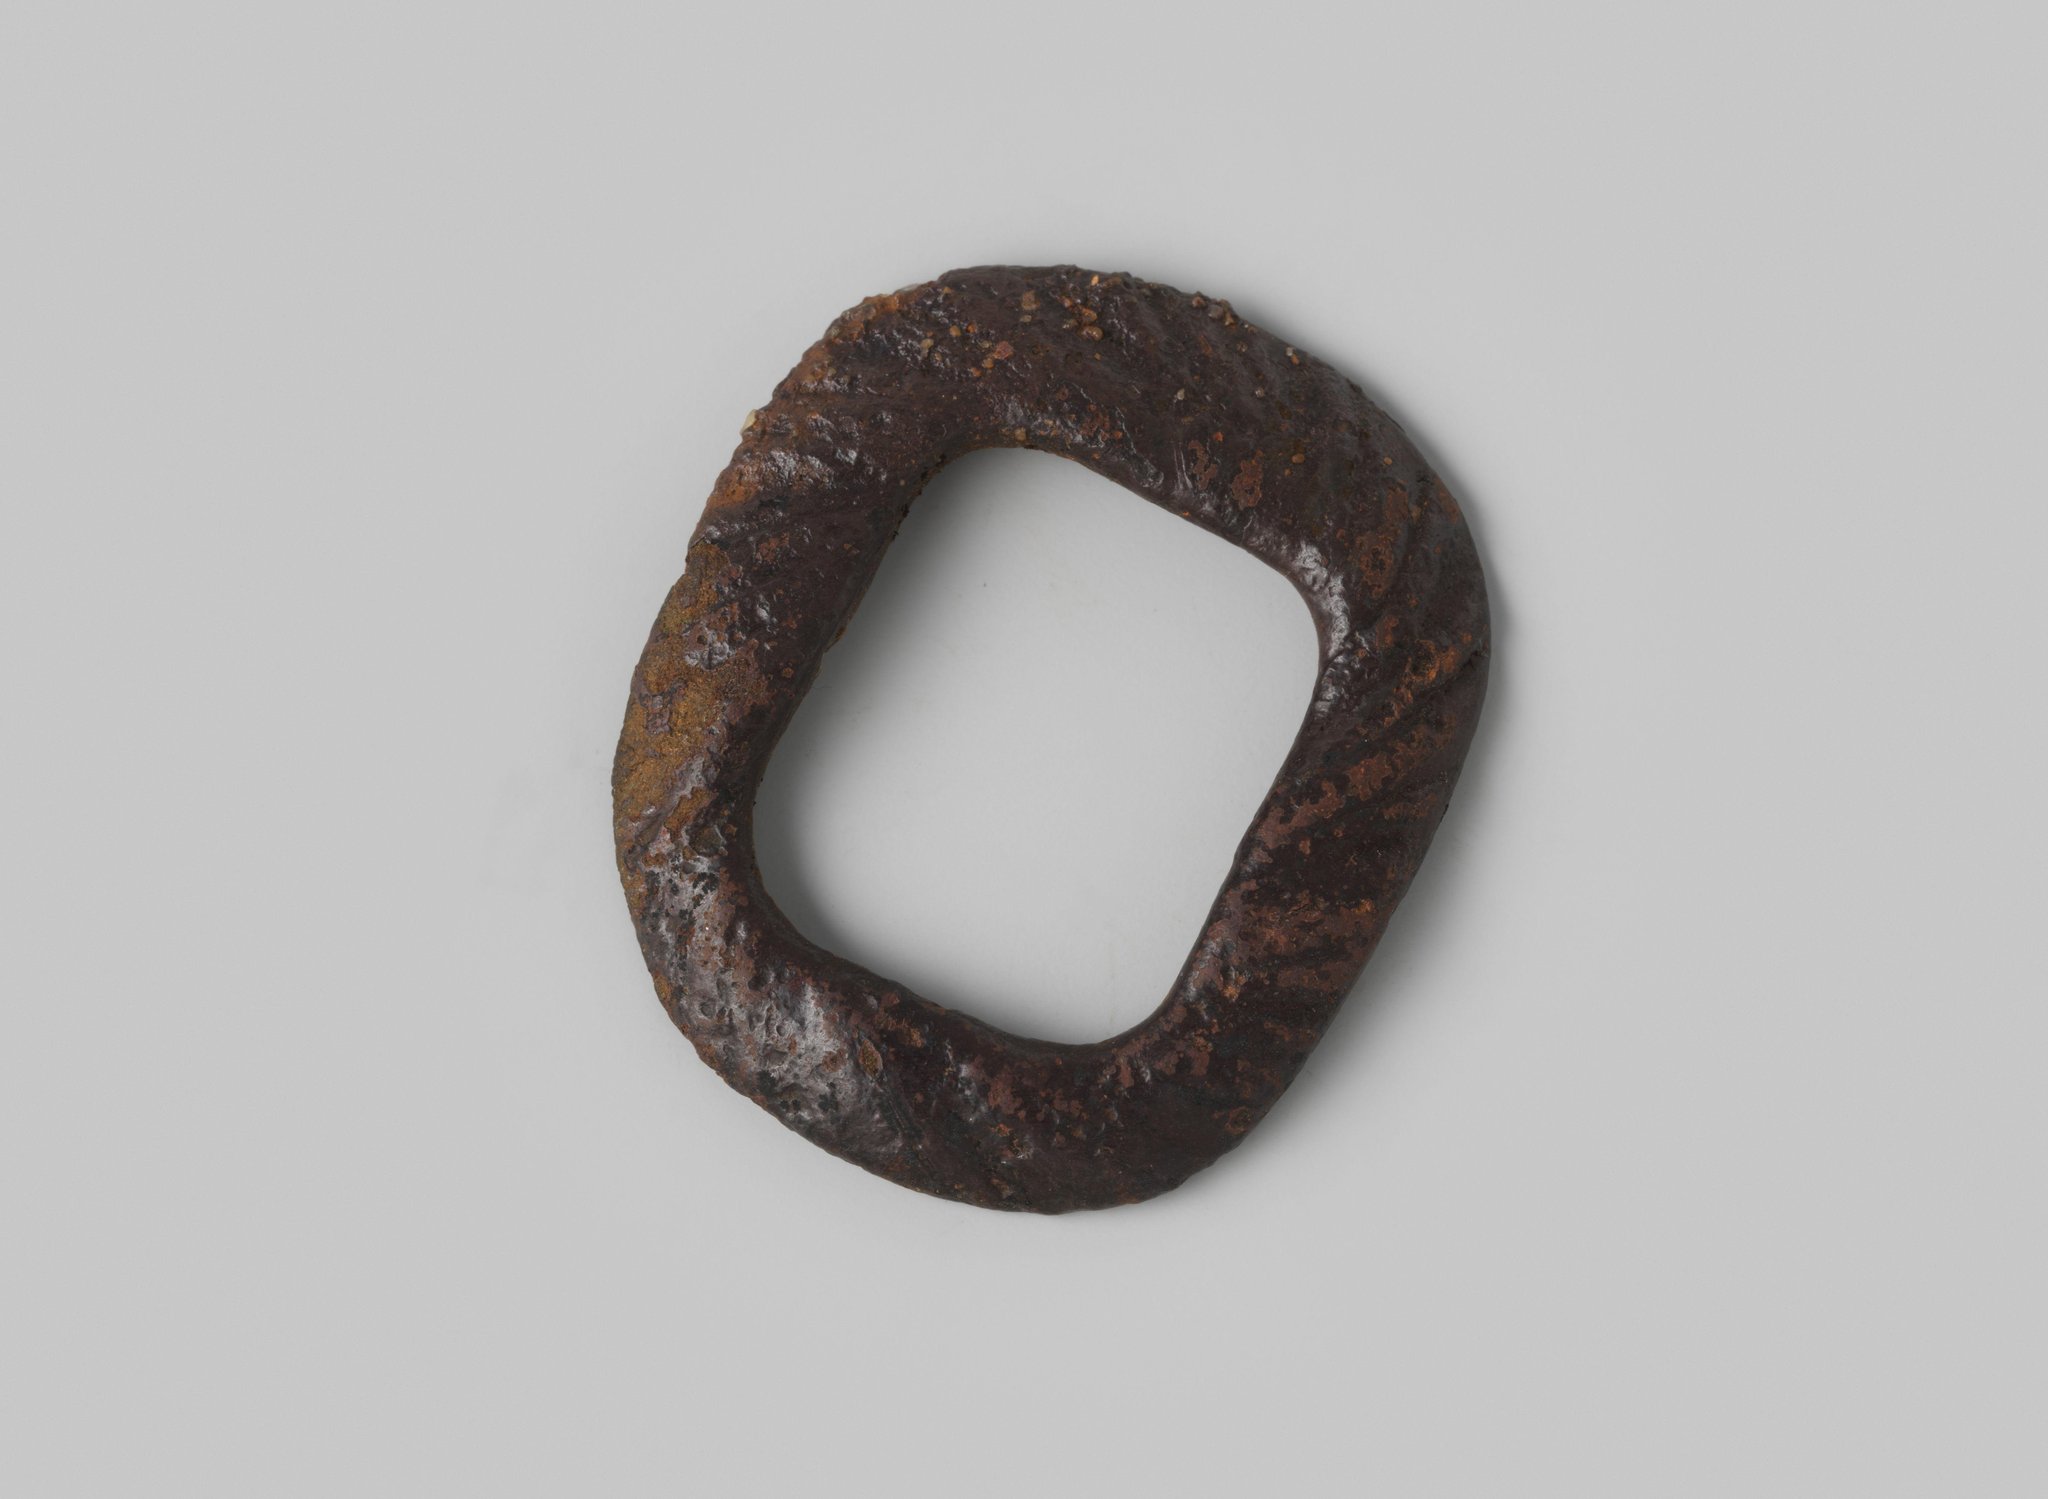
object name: shoe buckle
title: Schoengesp uit het wrak van de Oost-Indiëvaarder Hollandia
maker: Anonymous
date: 1700-1743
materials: copper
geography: netherlands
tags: verenigde oostindische compagnie, hollandia (schip), annet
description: Buckle, chape buckle, shoe buckle; ring, decoration id. NG 1980-27H2872.